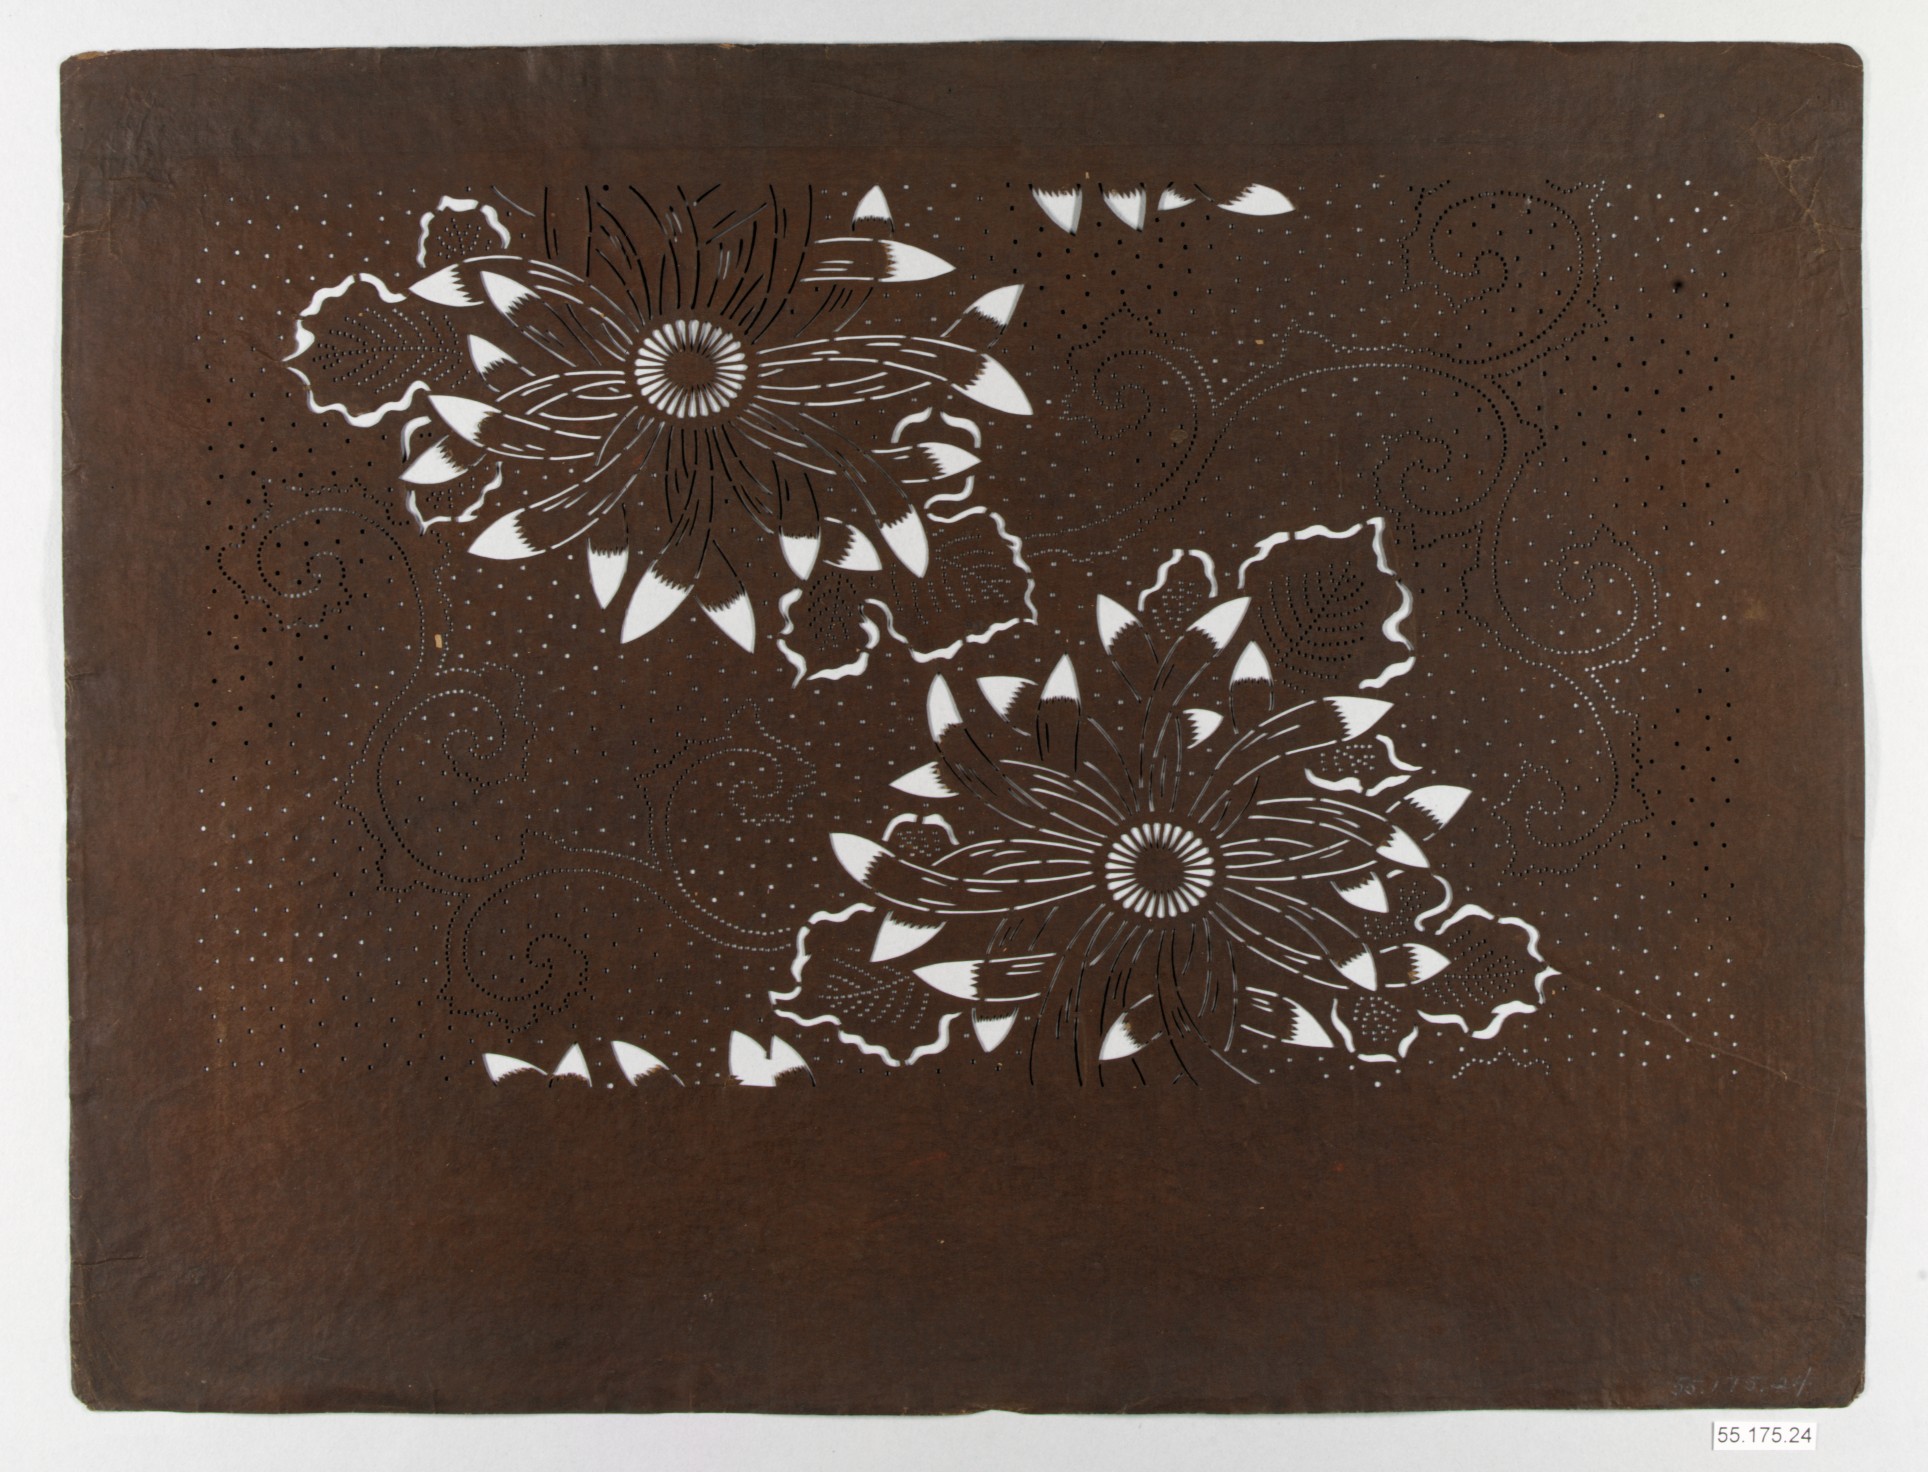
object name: stencil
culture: japanese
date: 1801-1900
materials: paper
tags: flowers